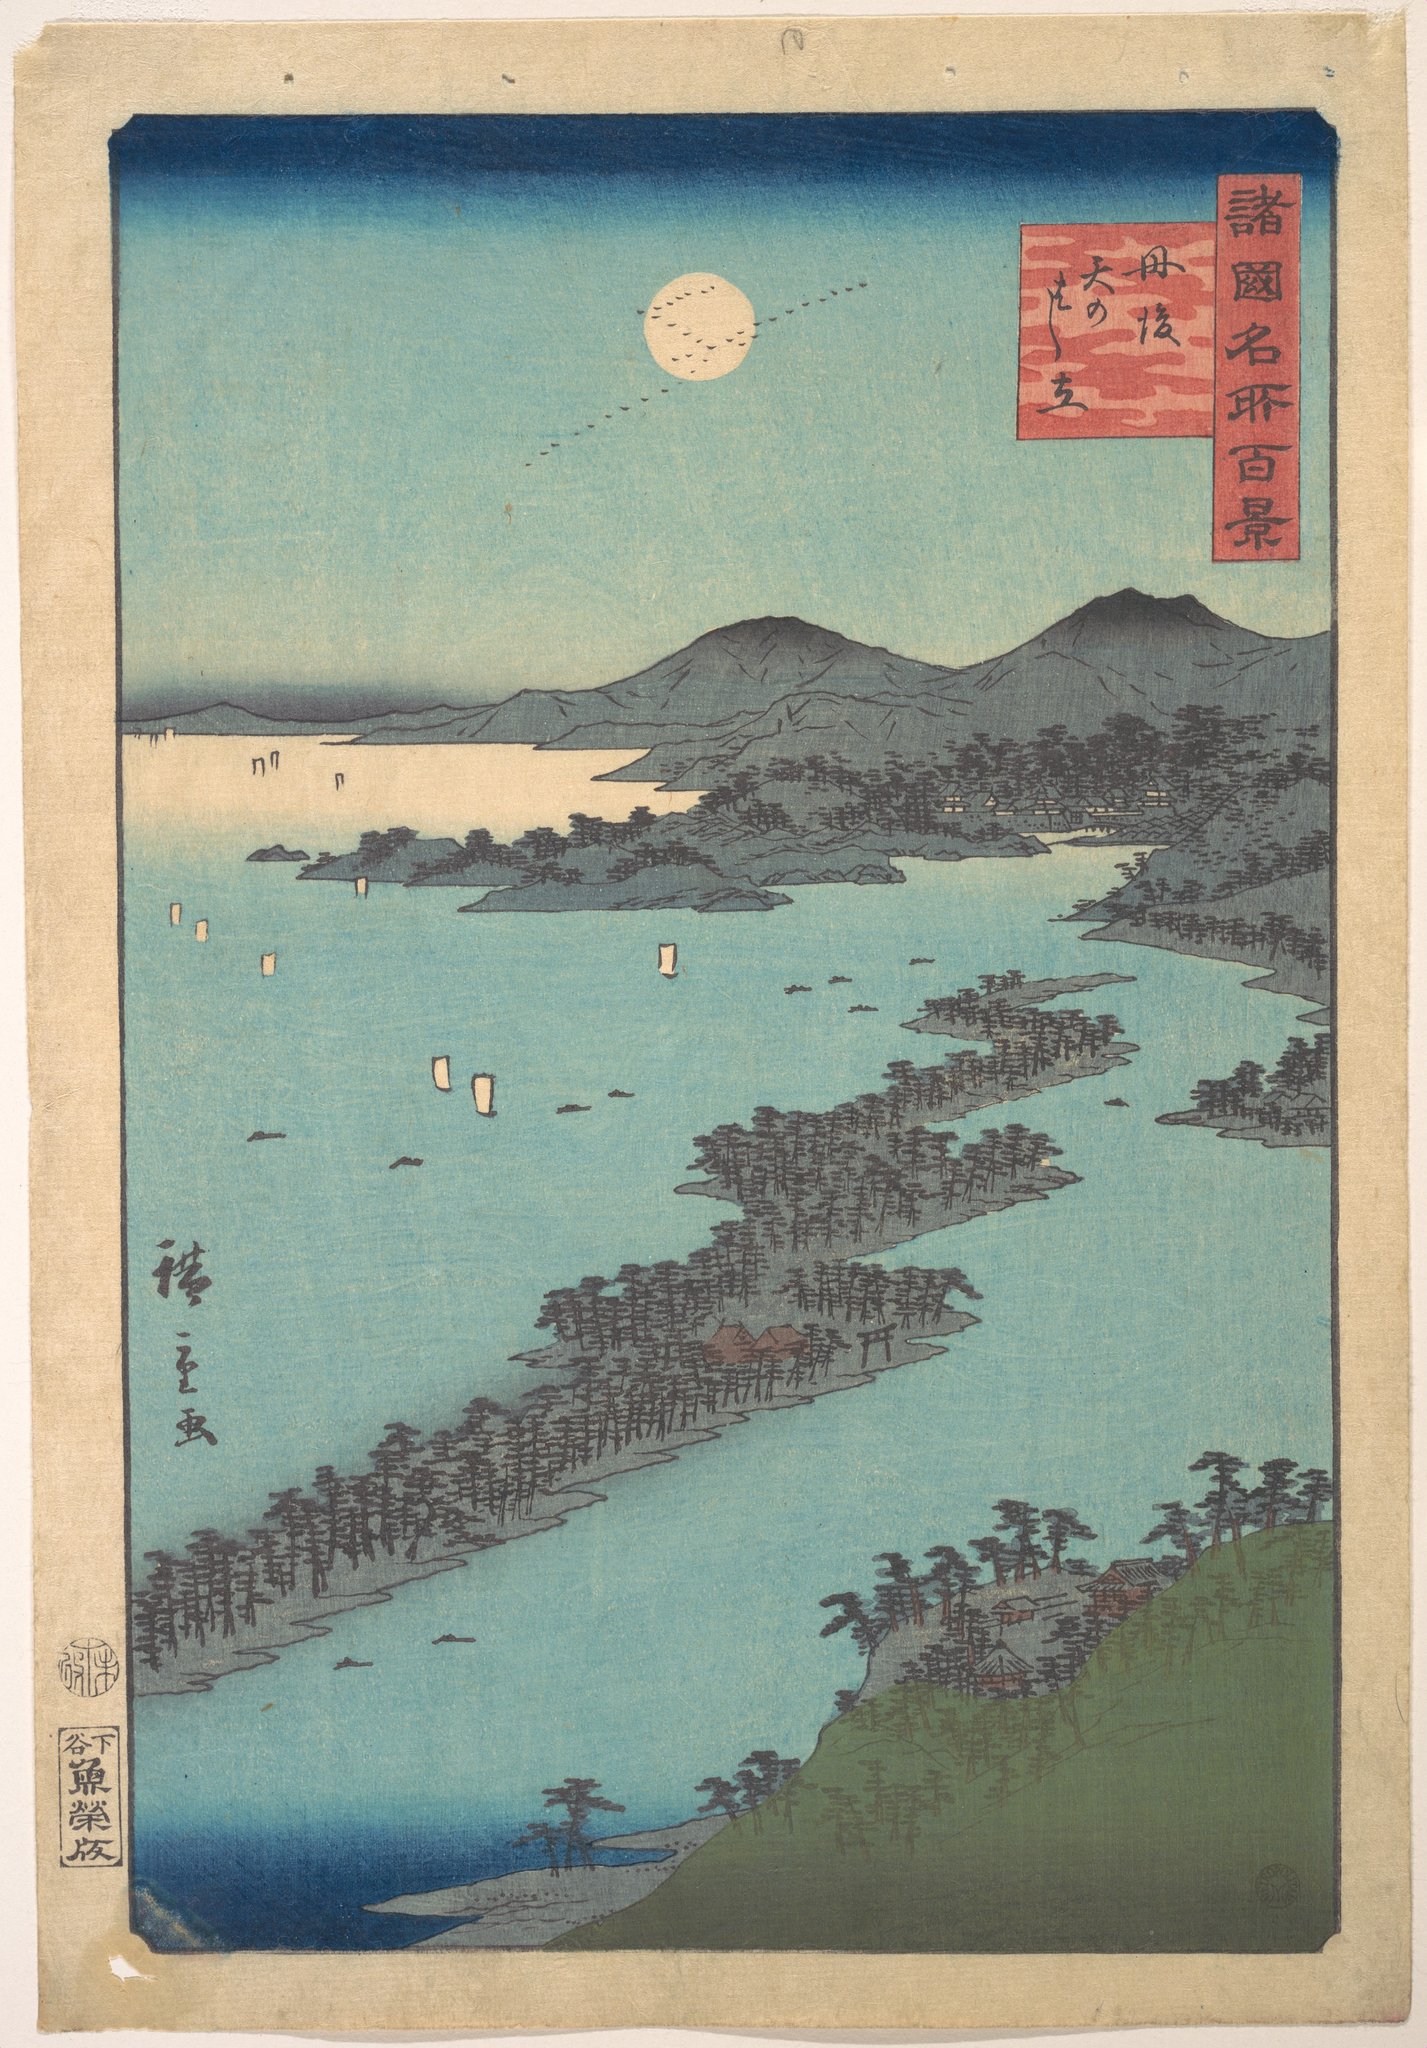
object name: print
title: Tango Amano Hashidate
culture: japanese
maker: utagawa hiroshige ii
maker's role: artist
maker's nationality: japanese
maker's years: 1826-1869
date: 1859-1861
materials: ink, paper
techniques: woodblock print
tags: moon,mountains,landscapes